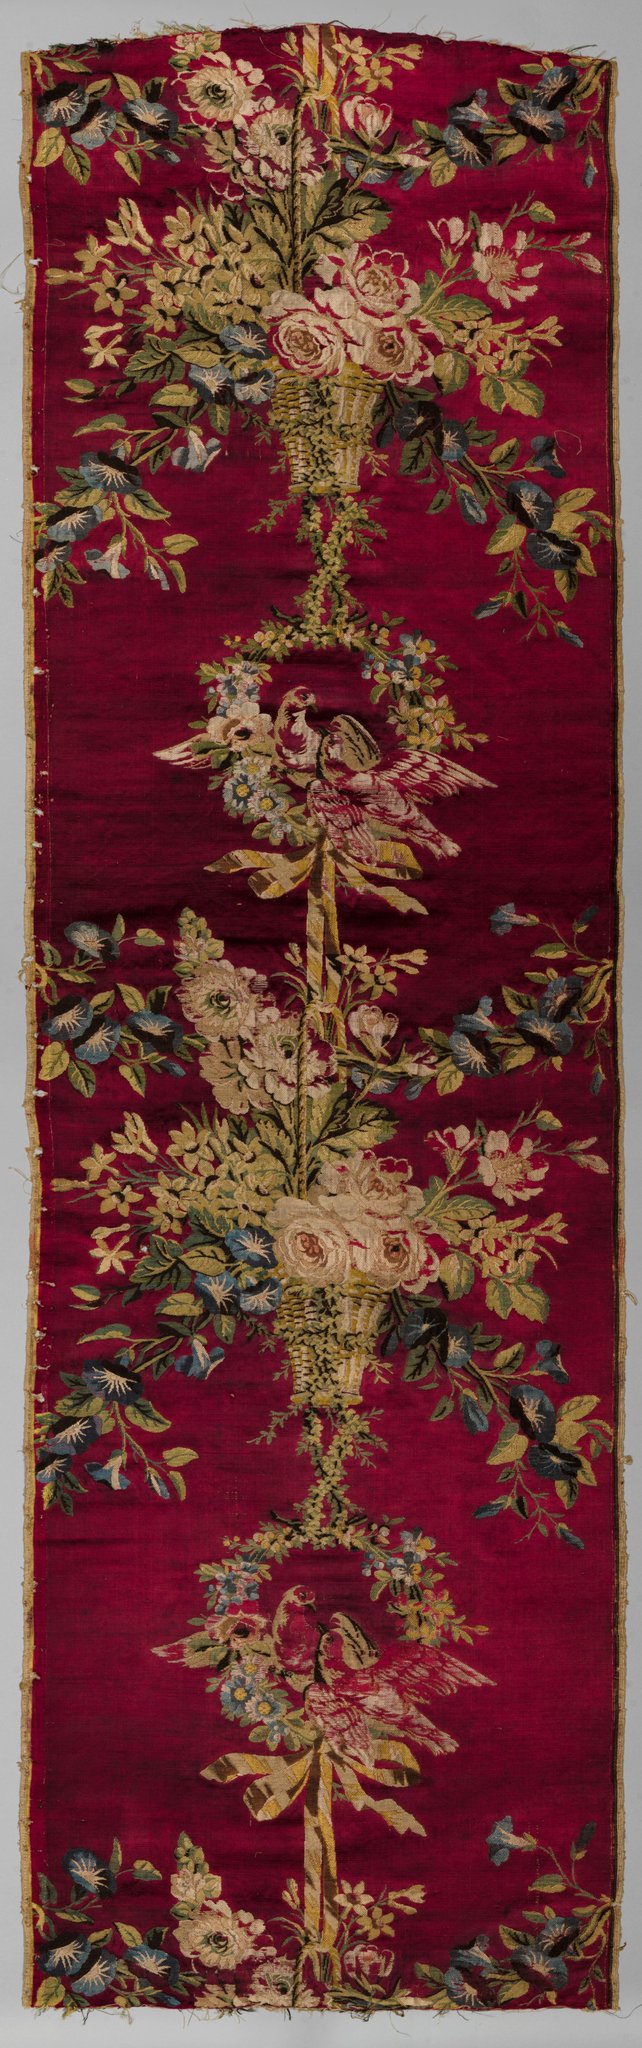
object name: upholstered wall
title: Wandbespanning van lampas met tortelduivenpatroon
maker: philippe de lasalle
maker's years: 1723-1805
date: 1770-1790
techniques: lampas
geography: lyon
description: Wandbespanning, bestaande uit een baan lampas. Tortelduifpatroon.